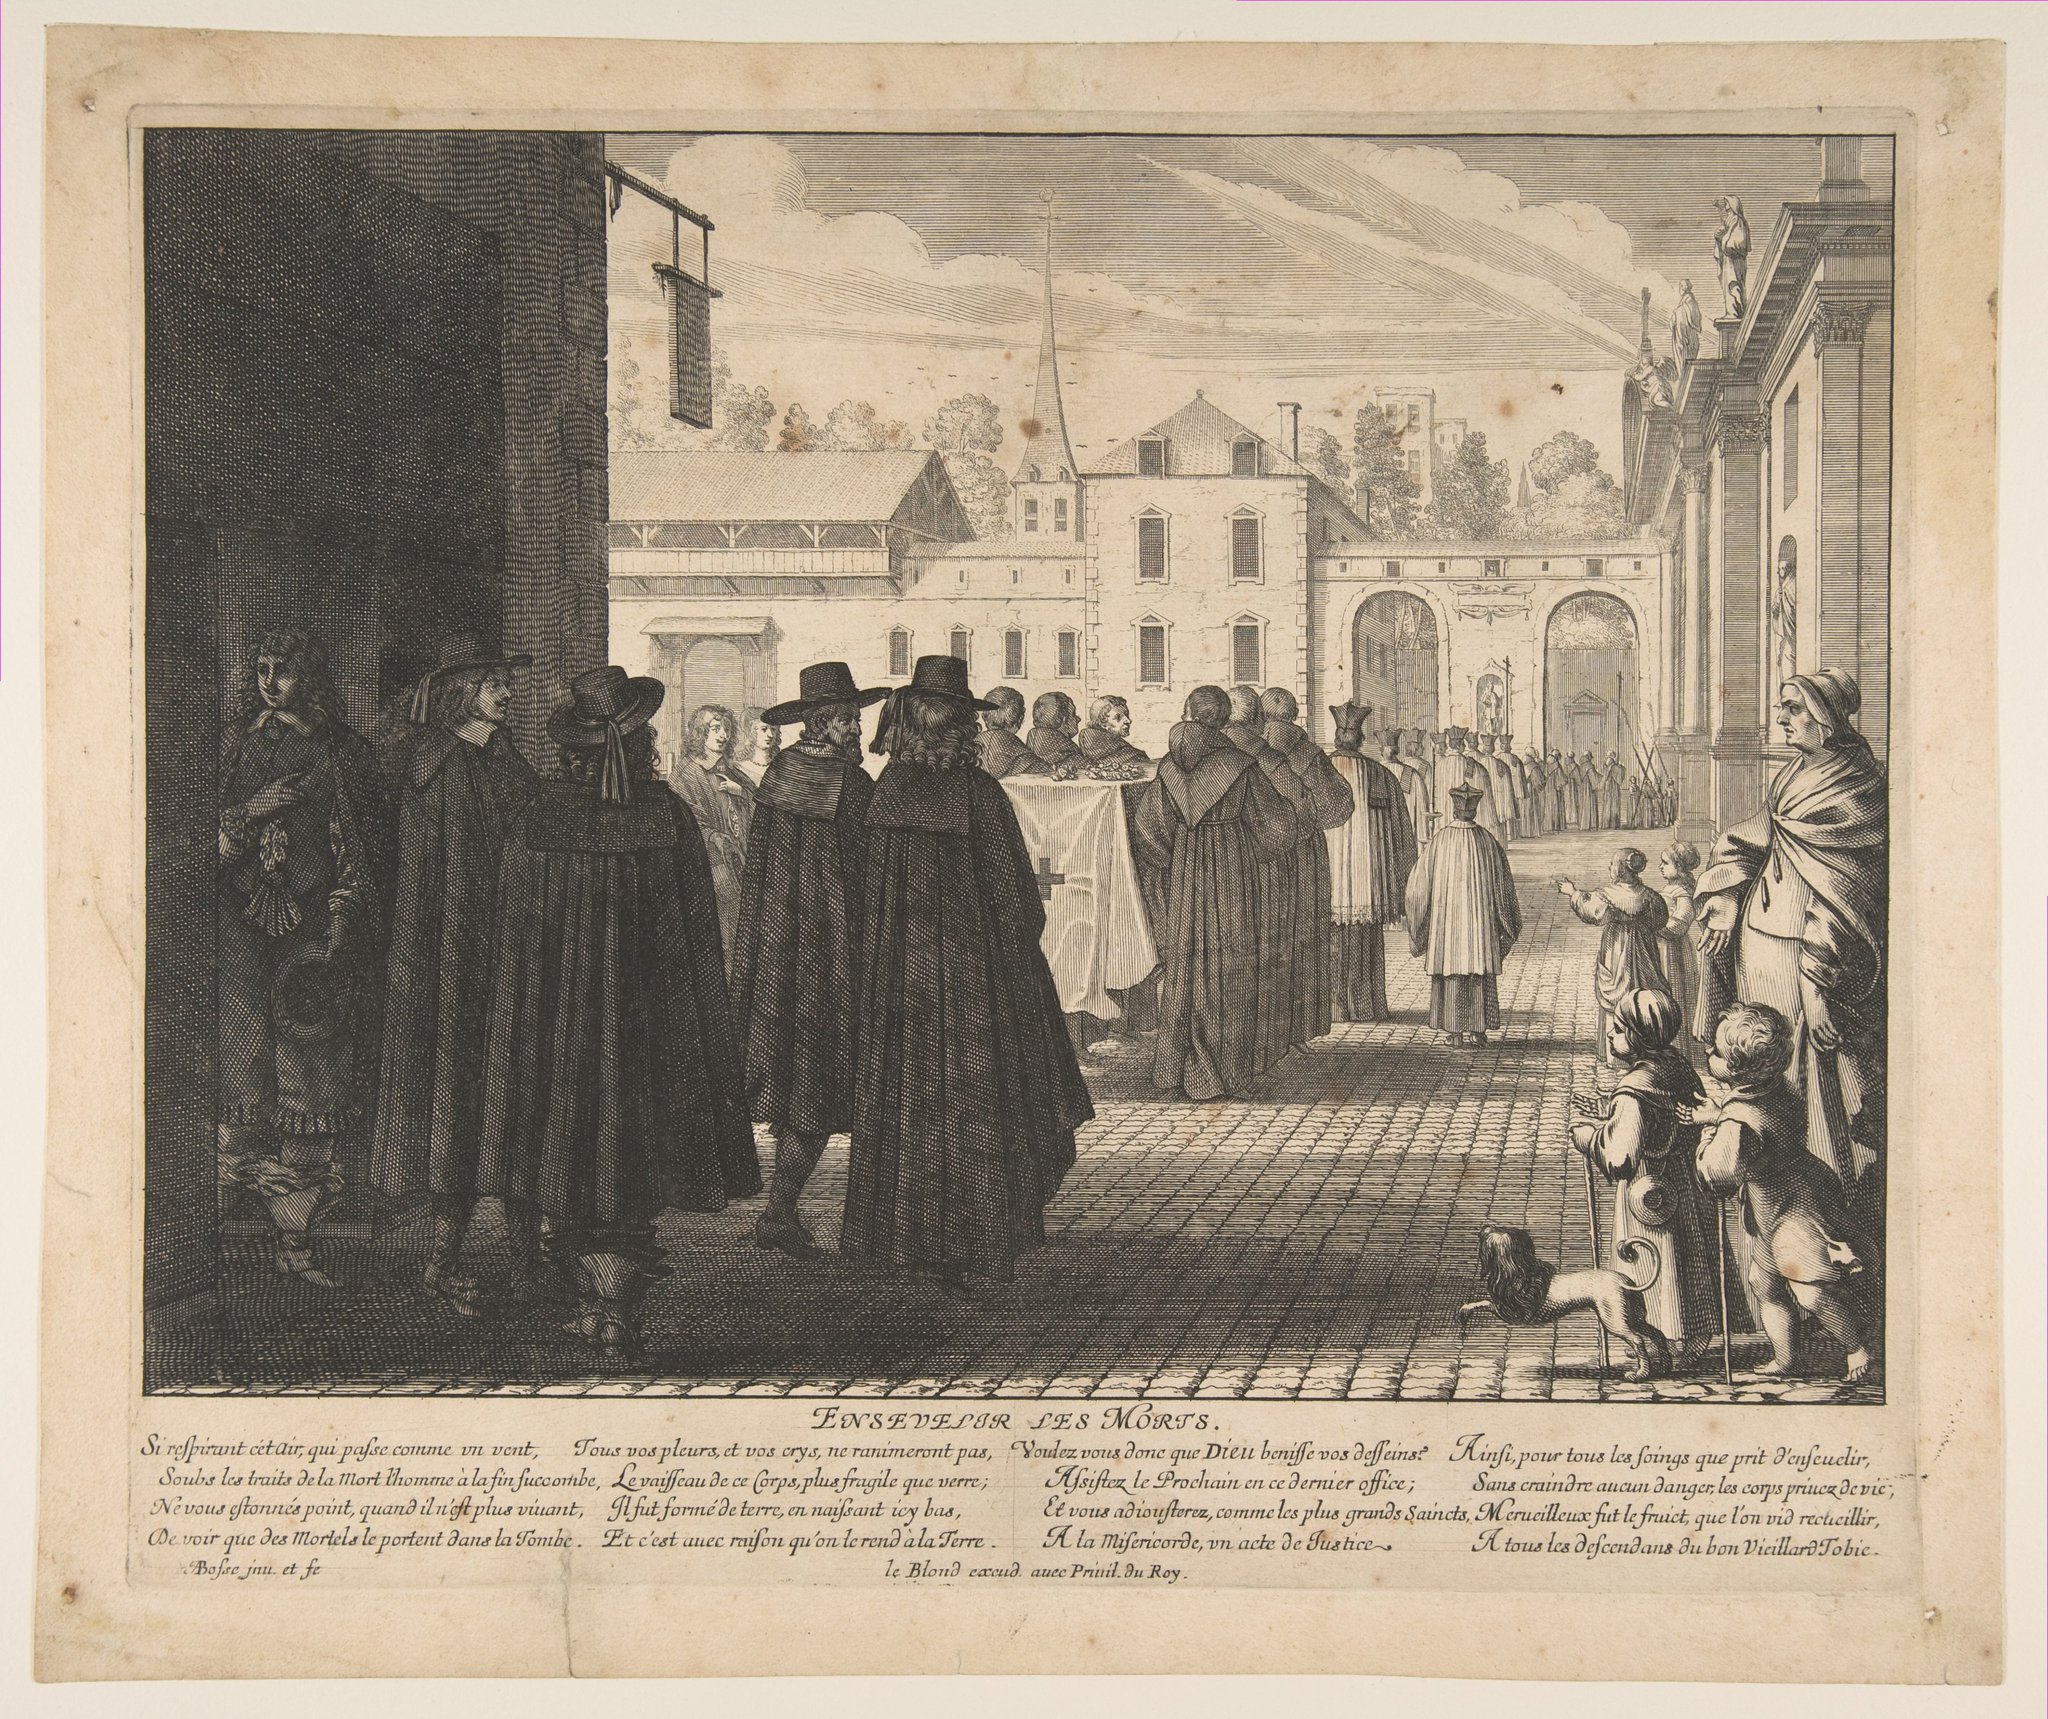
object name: print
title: Burying the Dead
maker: abraham bosse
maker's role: artist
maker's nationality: french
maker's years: 1602-1676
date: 1635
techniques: engraving, etching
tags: men,women,lions,death